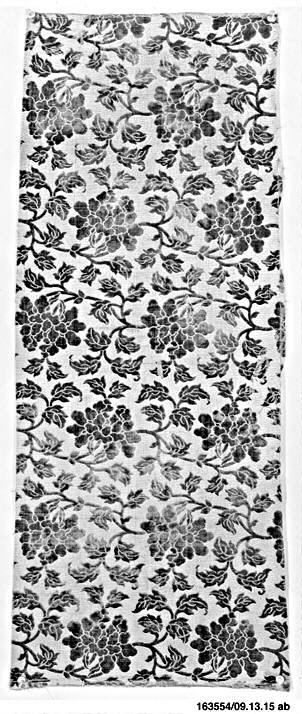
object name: piece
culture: chinese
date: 1701-1800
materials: metal thread, silk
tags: leaves